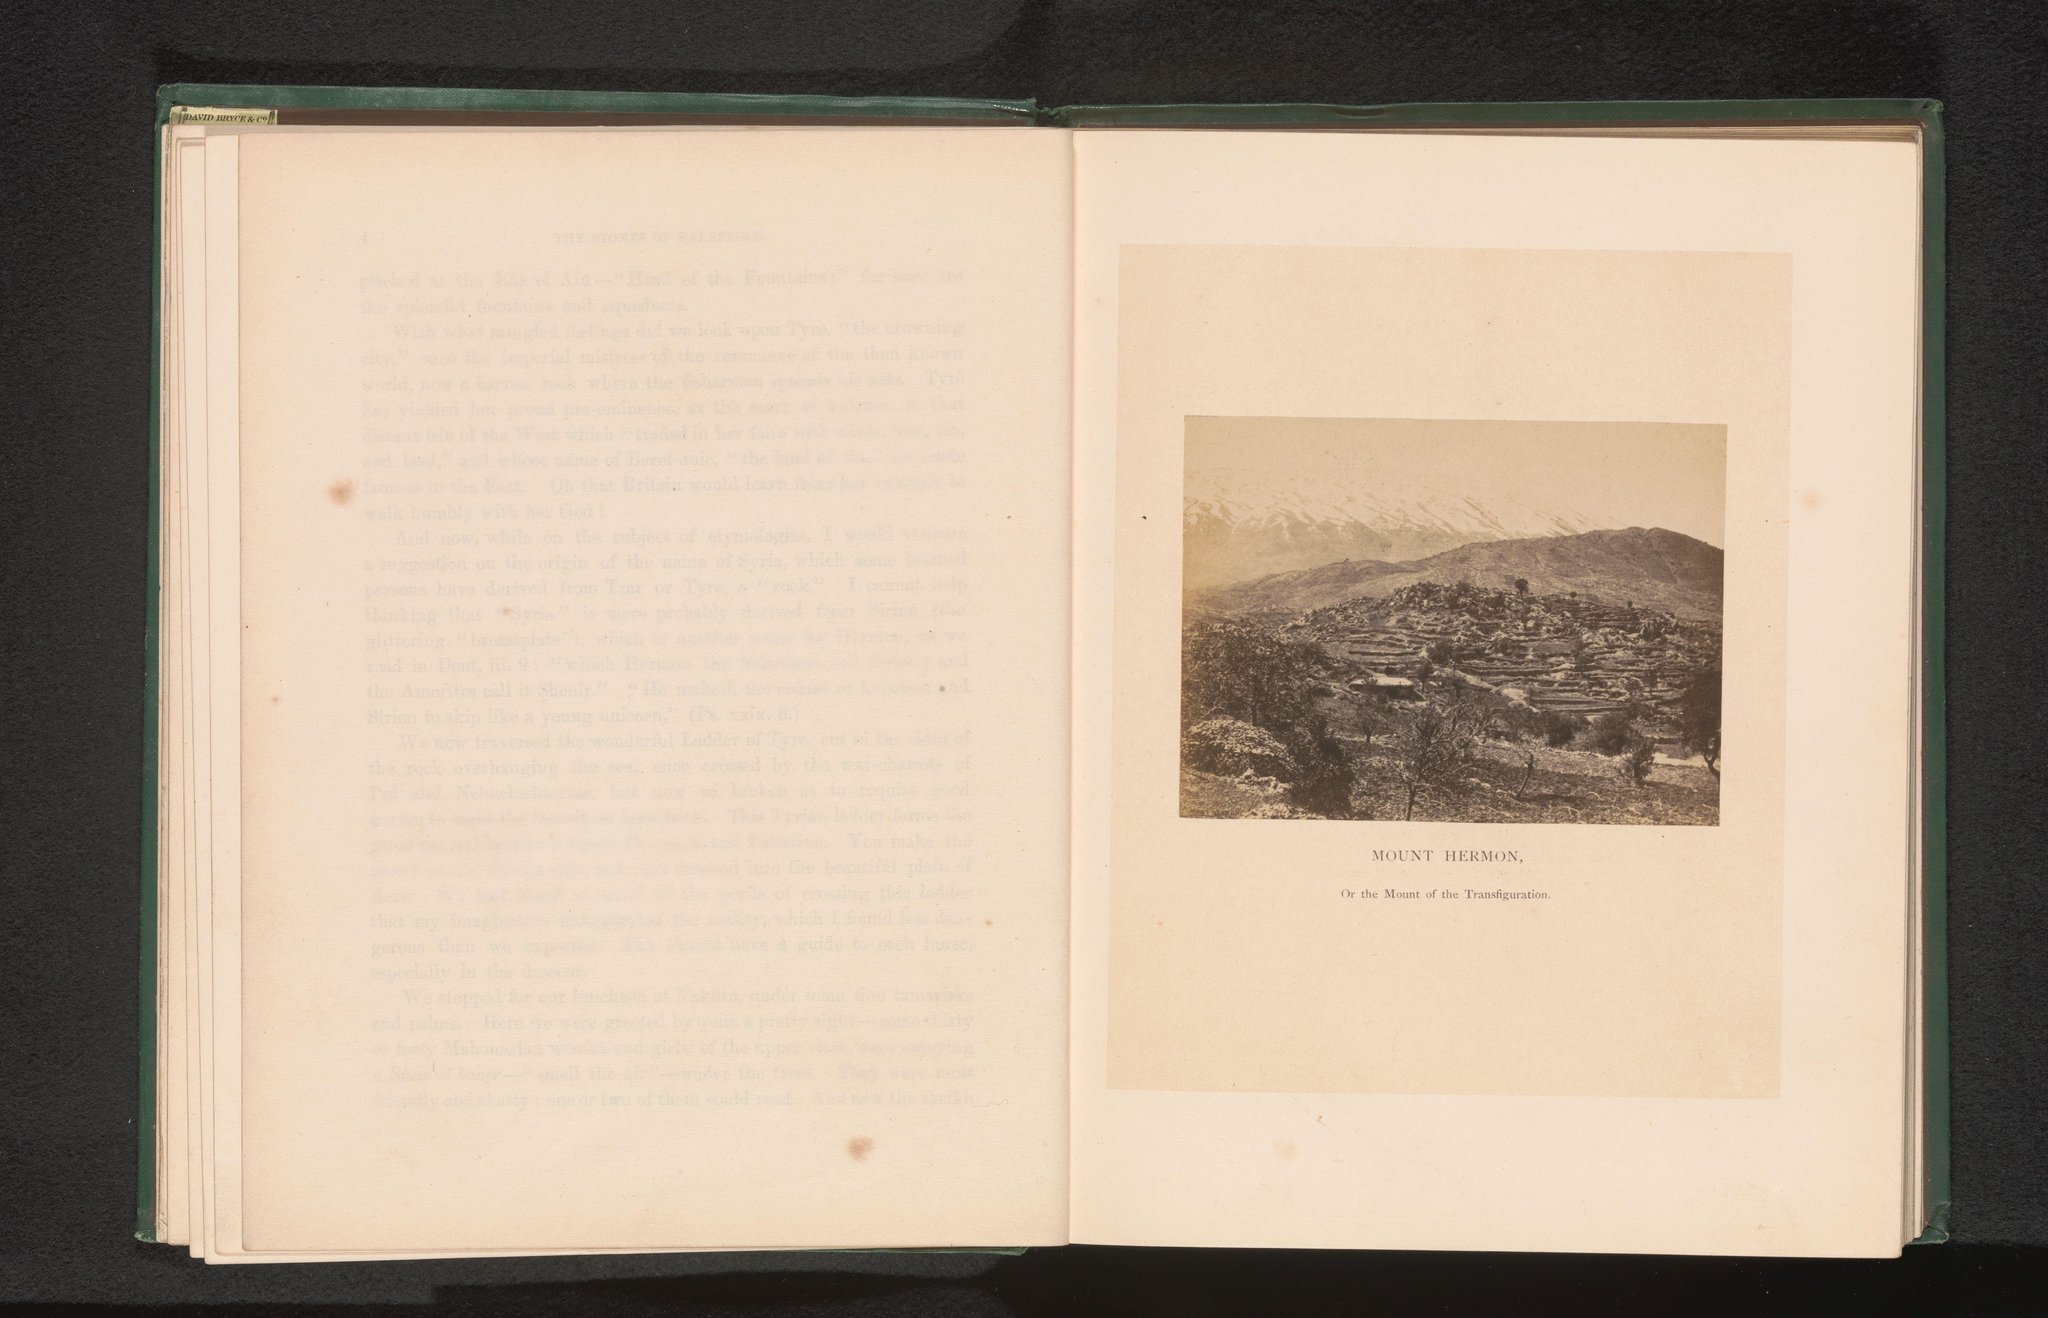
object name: page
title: Mount Hermon, or the Mount of the Transfiguration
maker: francis bedford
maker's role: print maker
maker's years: 1815-1894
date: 1860-1865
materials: photographic support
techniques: albumen print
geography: palestine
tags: mountains